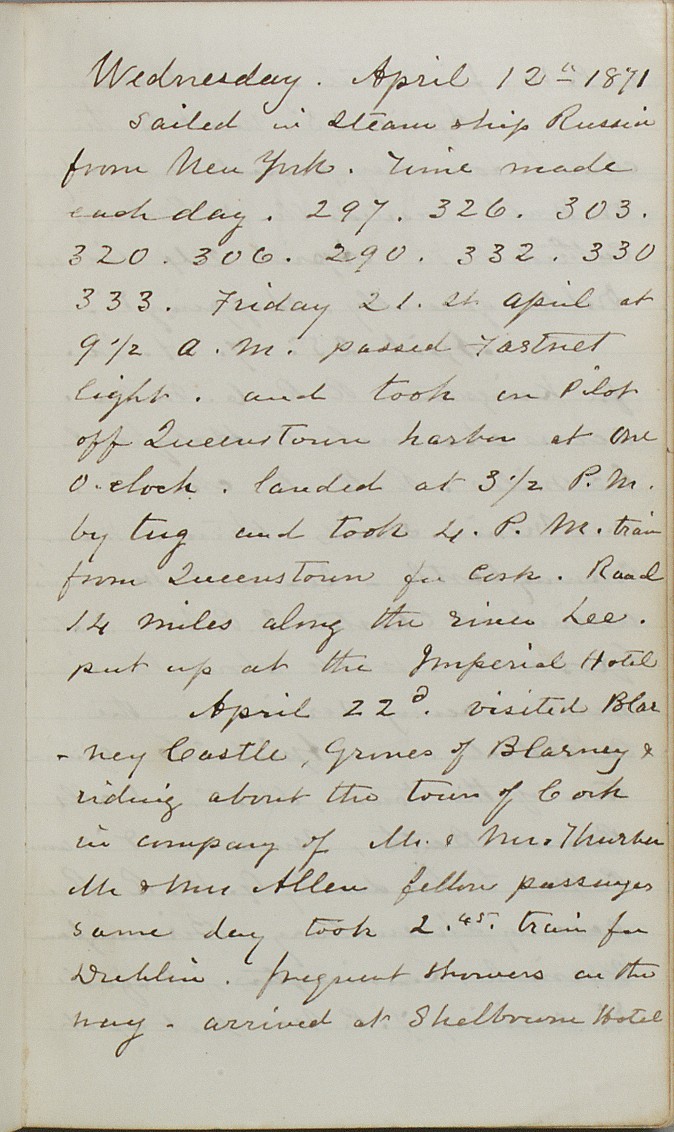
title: Diaries of Samuel P. Avery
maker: samuel putnam avery sr.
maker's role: author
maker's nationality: american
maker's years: 1822-1904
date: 1871-1882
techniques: bookbinding